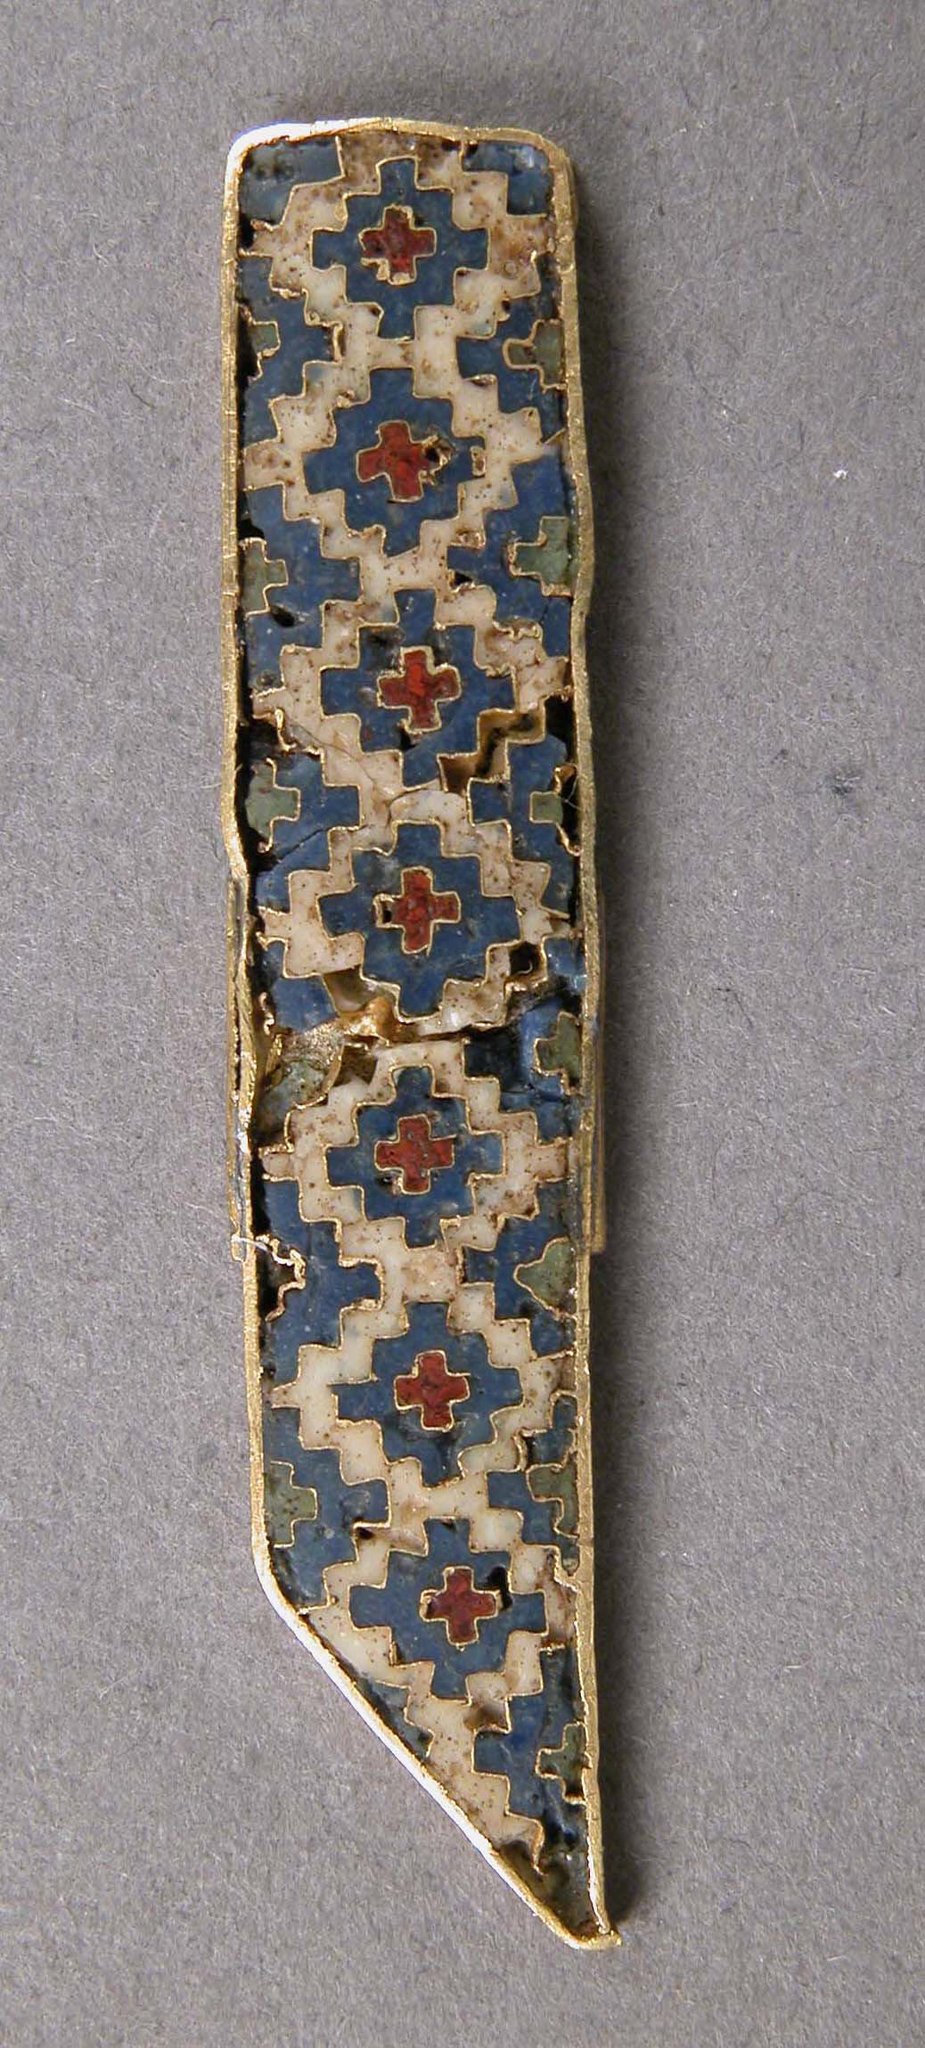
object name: border fragment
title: Element of a Border for an Icon Frame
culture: byzantine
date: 901-1000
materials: enamel, gold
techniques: enamel